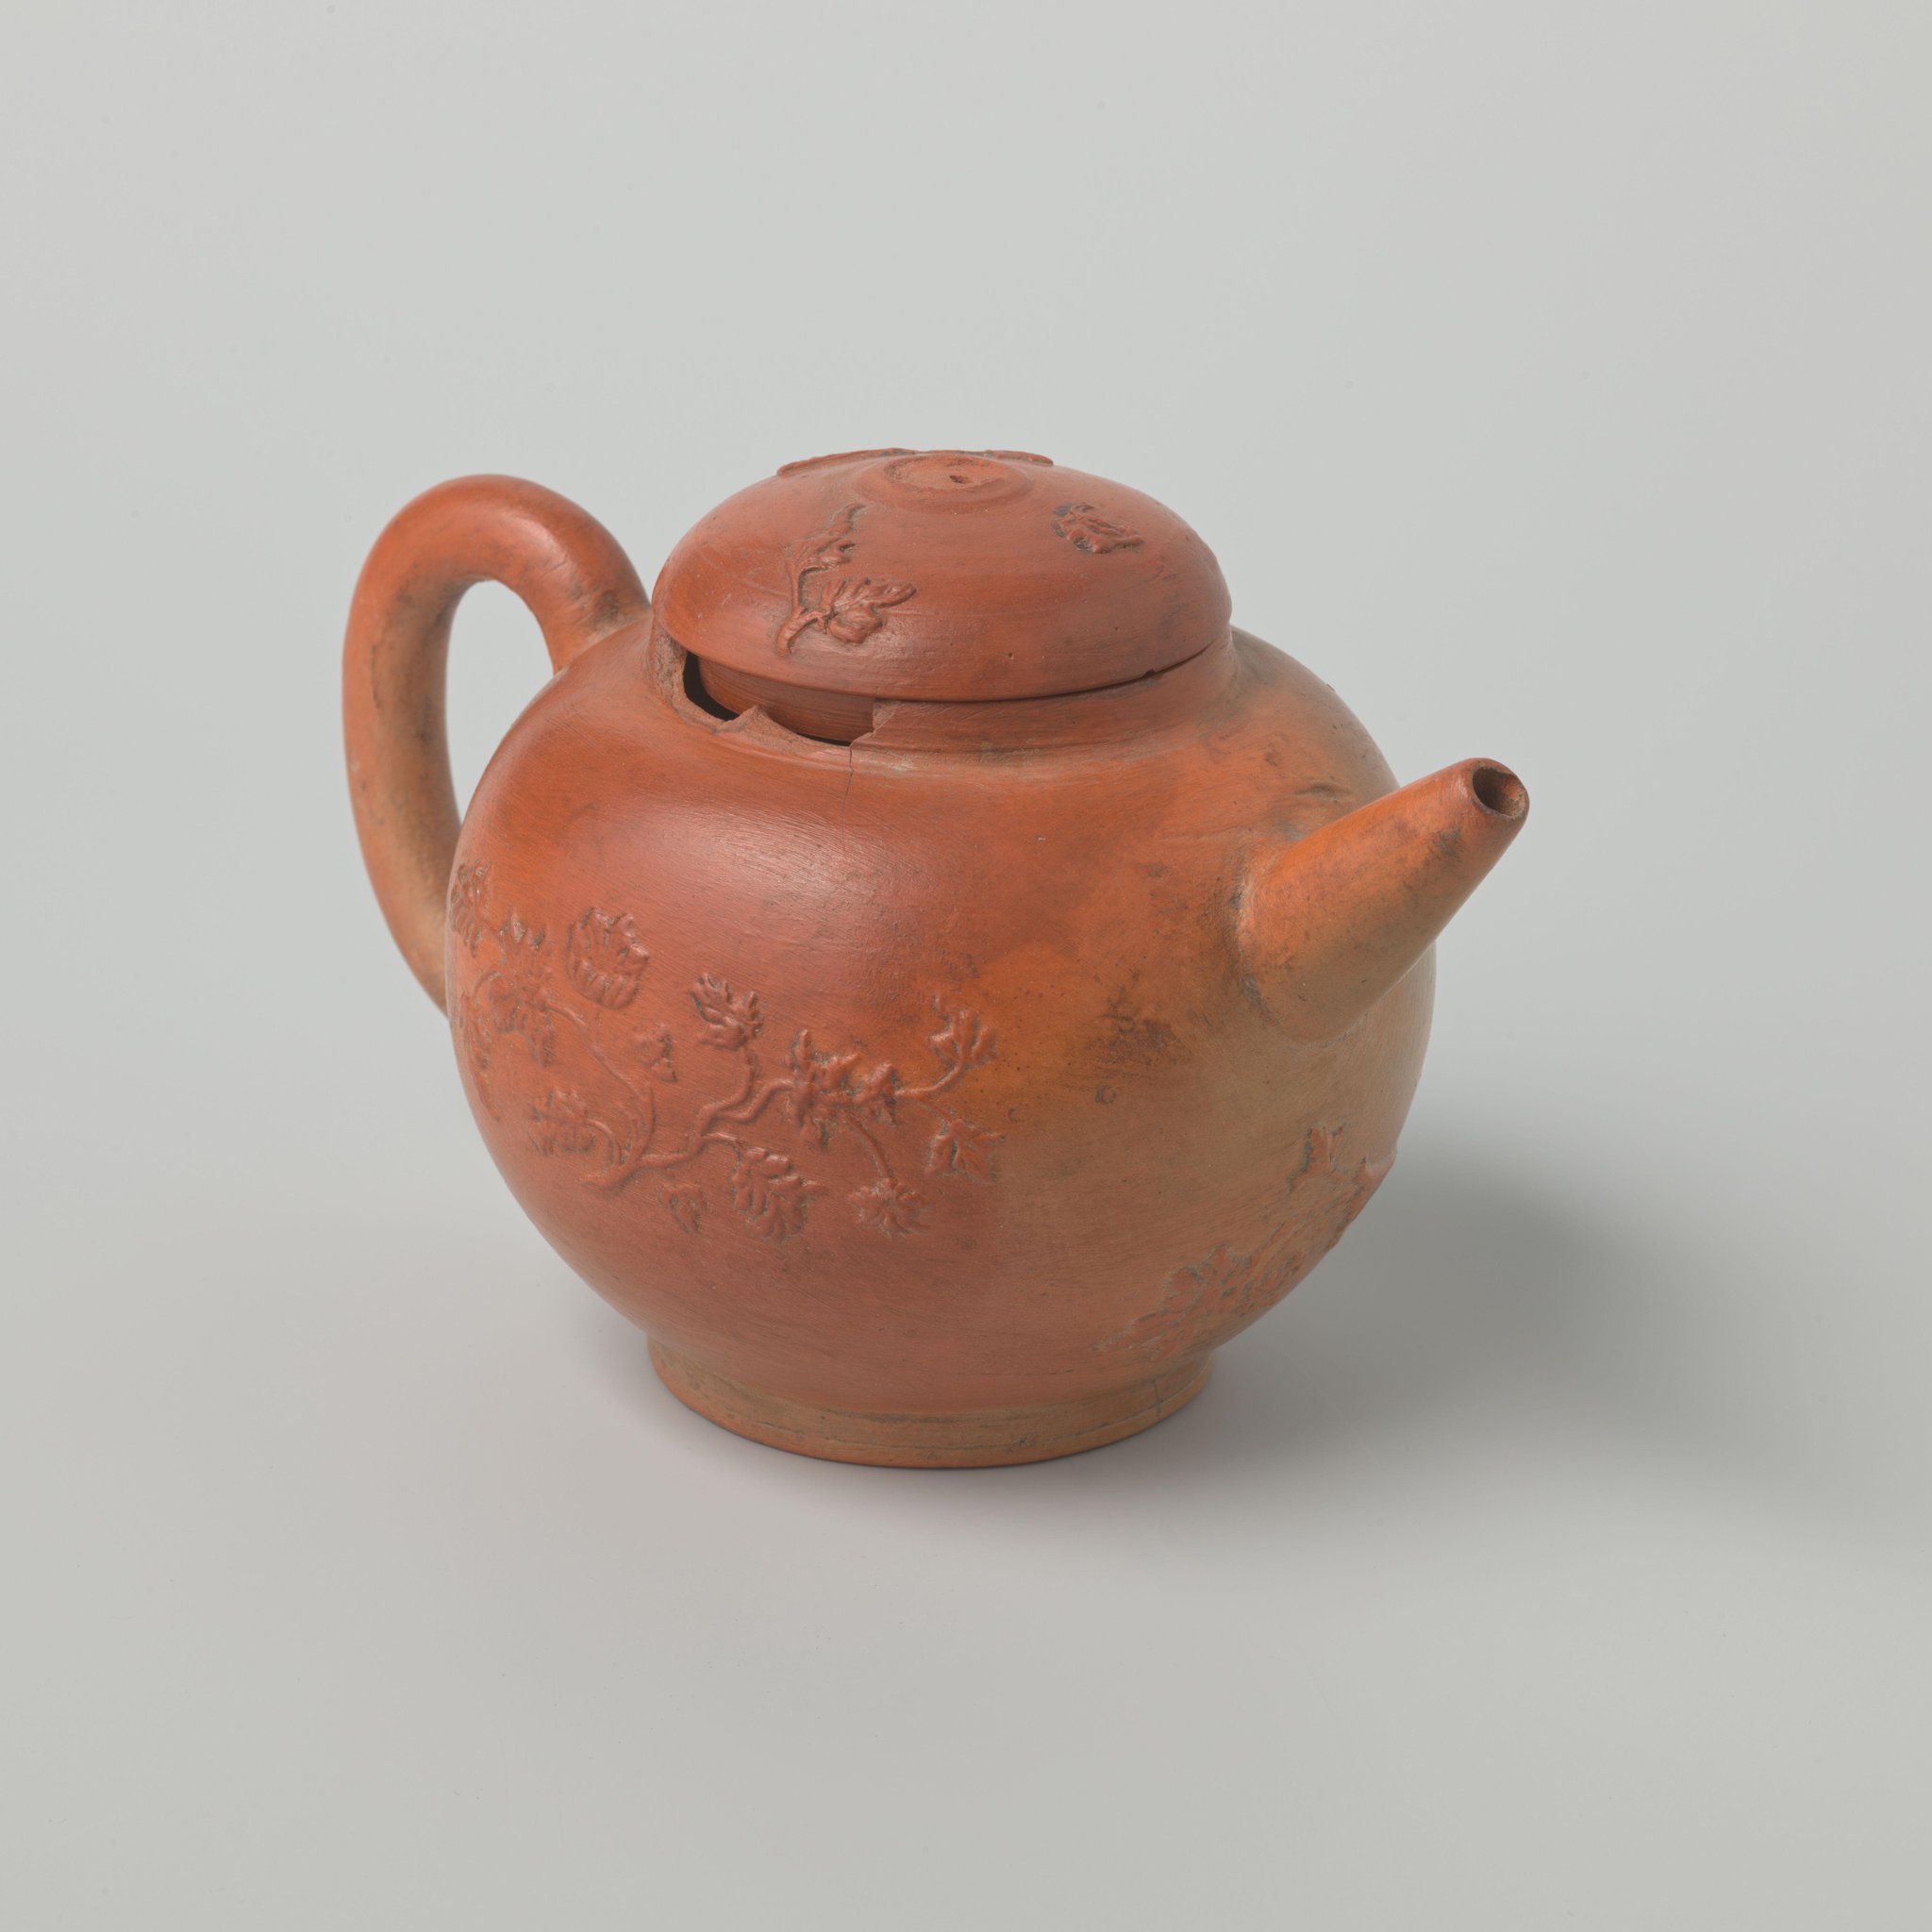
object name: teapot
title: Theepot met bloemtakken in reliëf (De Caluwe bakafval)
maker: jacobus de caluwe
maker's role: plateelbakkerij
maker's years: -1730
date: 1700-1725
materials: earthenware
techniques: firing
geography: delft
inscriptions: mark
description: Toegeschreven aan Jacobus de Caluwe, omdat dit voorwerp samen met gemerkte stukken (‘Jacobus De Caluwe’ en rennend hert) gevonden is op de plaats waar zich De Caluwes tweede werkplaats bevond. Er is een duidelijke stilistische overeenkomst tussen de gemerkte en niet gemerkte voorwerpen uit deze archeologische vondst.